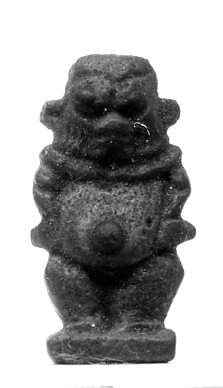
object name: amulet, be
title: Bes amulet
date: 664-332 BCE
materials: faience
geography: egypt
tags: bes